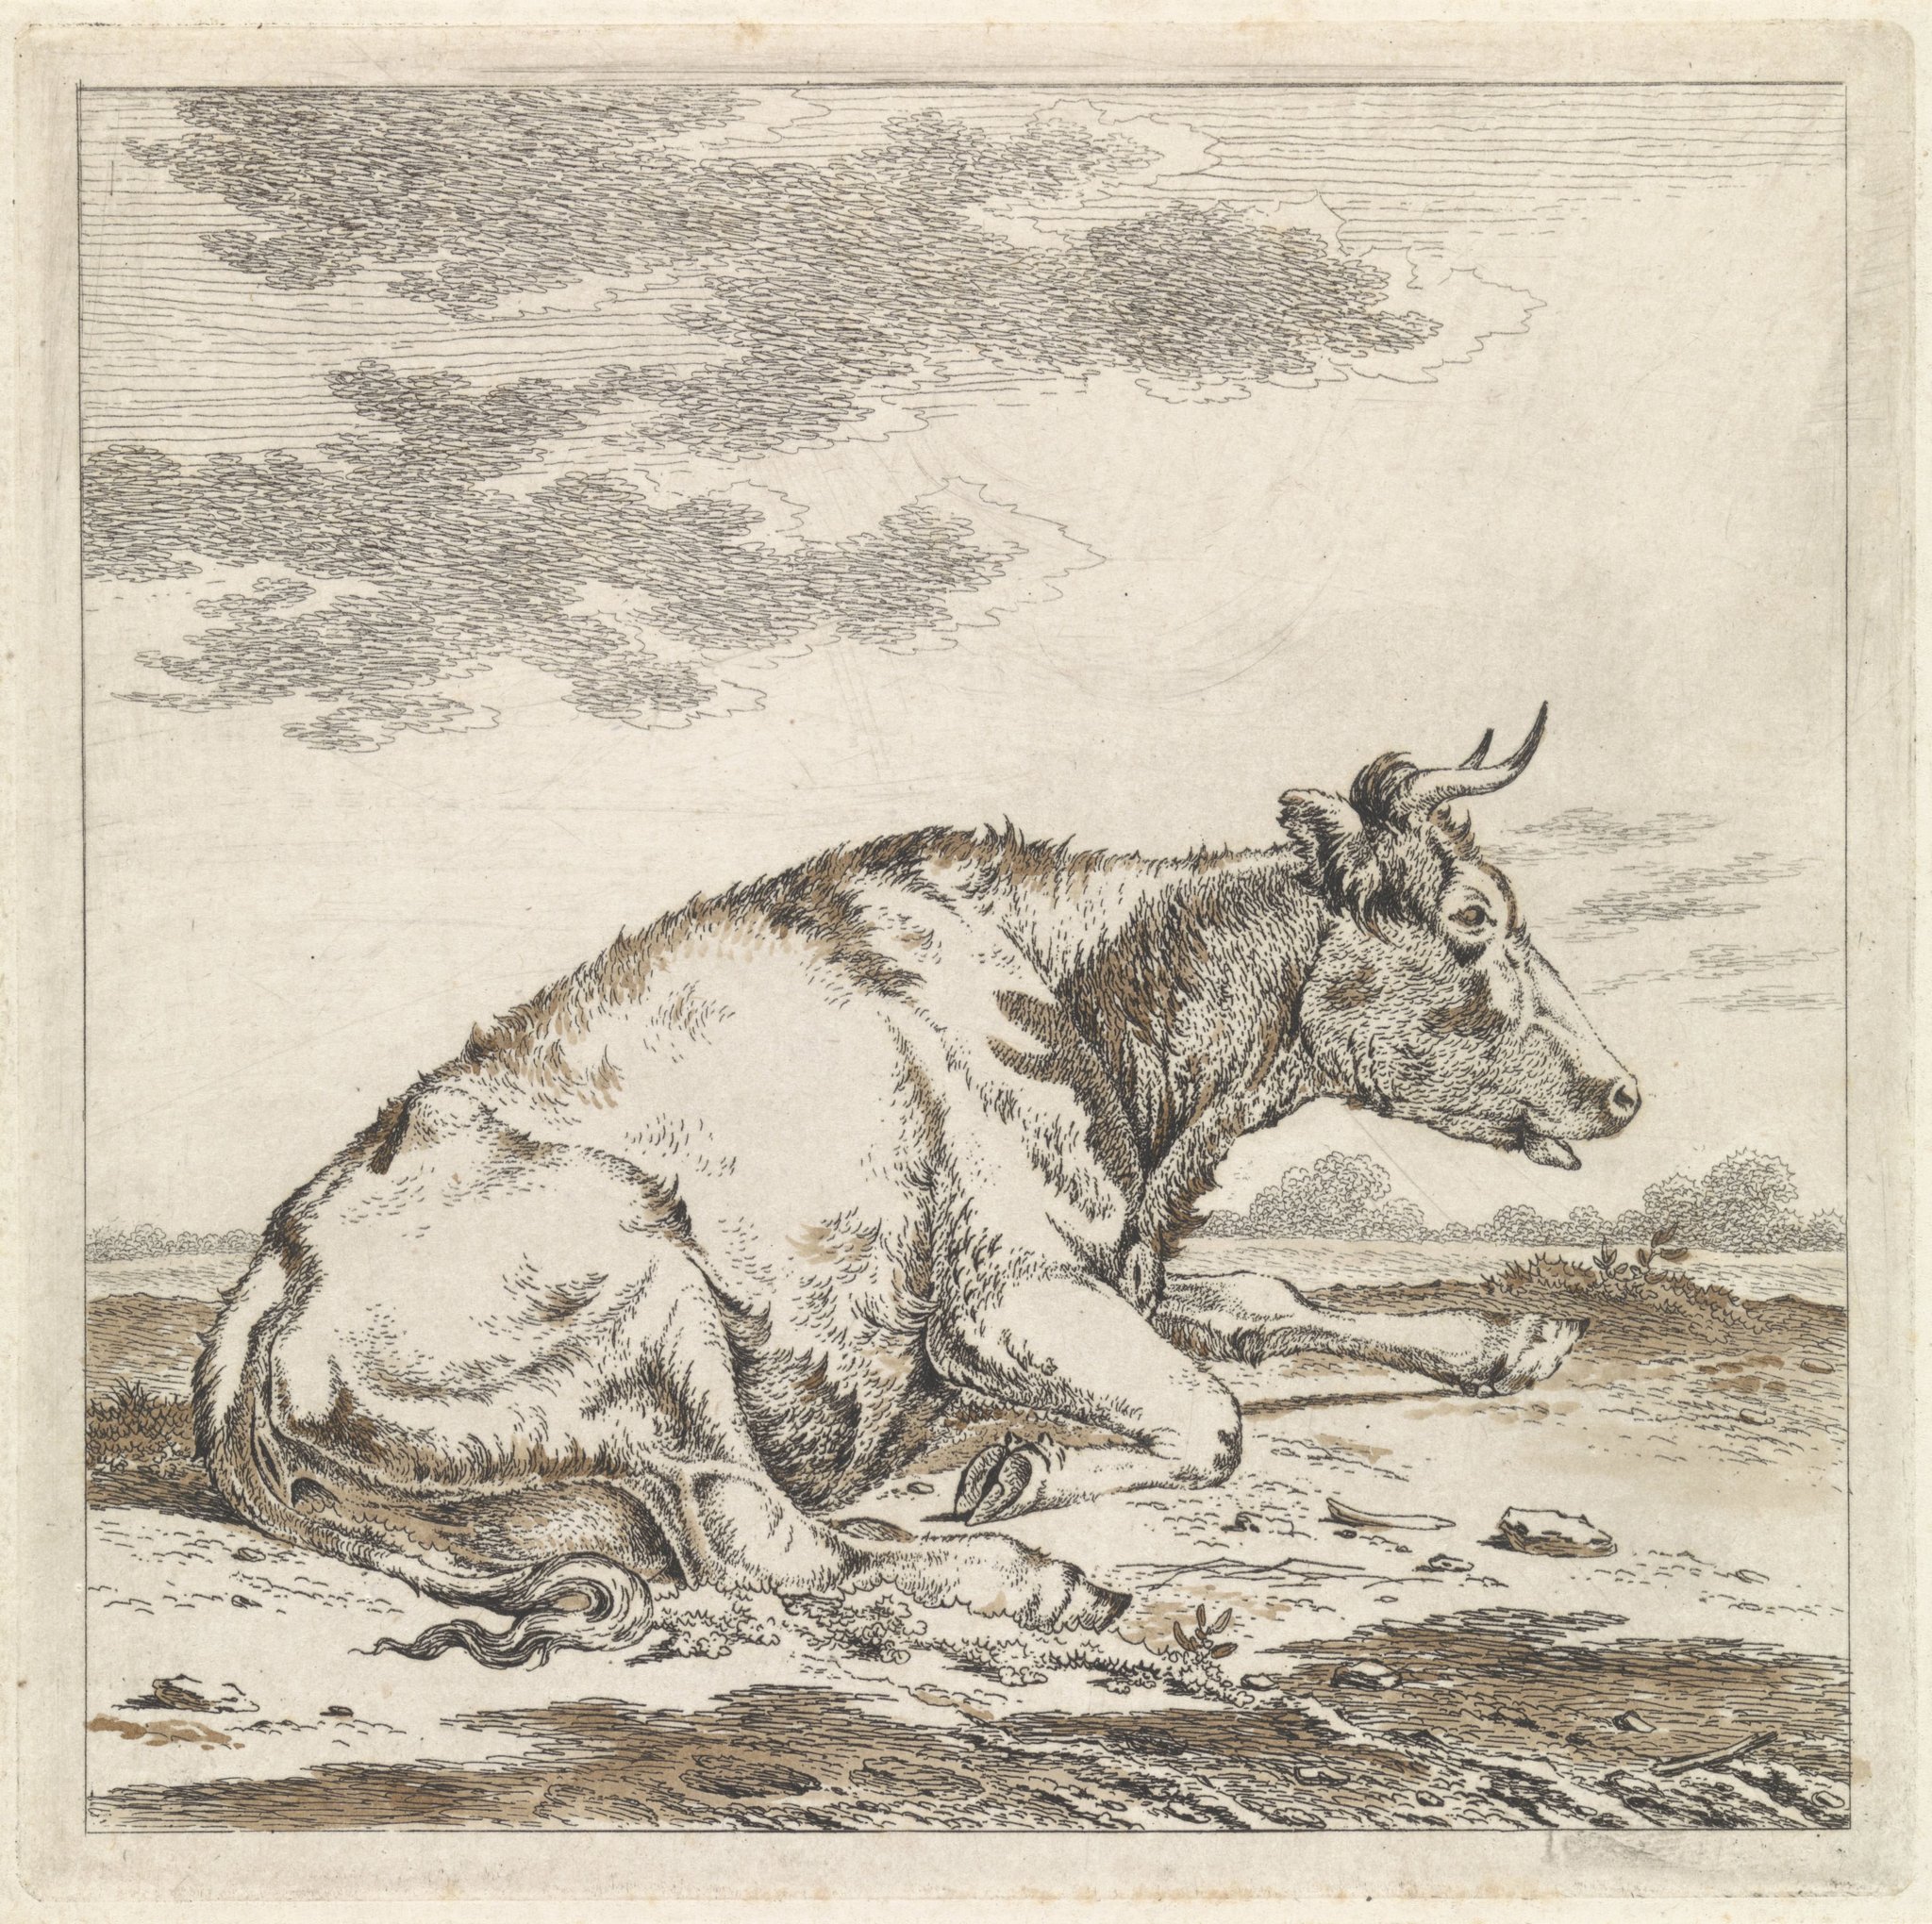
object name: print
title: Liggende koe, naar rechts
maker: pieter janson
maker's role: draughtsman, print maker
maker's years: 1765-1851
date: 1780-1851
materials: paper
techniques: brush, etching, pen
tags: cow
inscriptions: collector's mark: Lugt 2228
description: Landschap met liggende koe, naar rechts. Proefdruk met aanpassingen van de kunstenaar in pen en penseel in bruin.